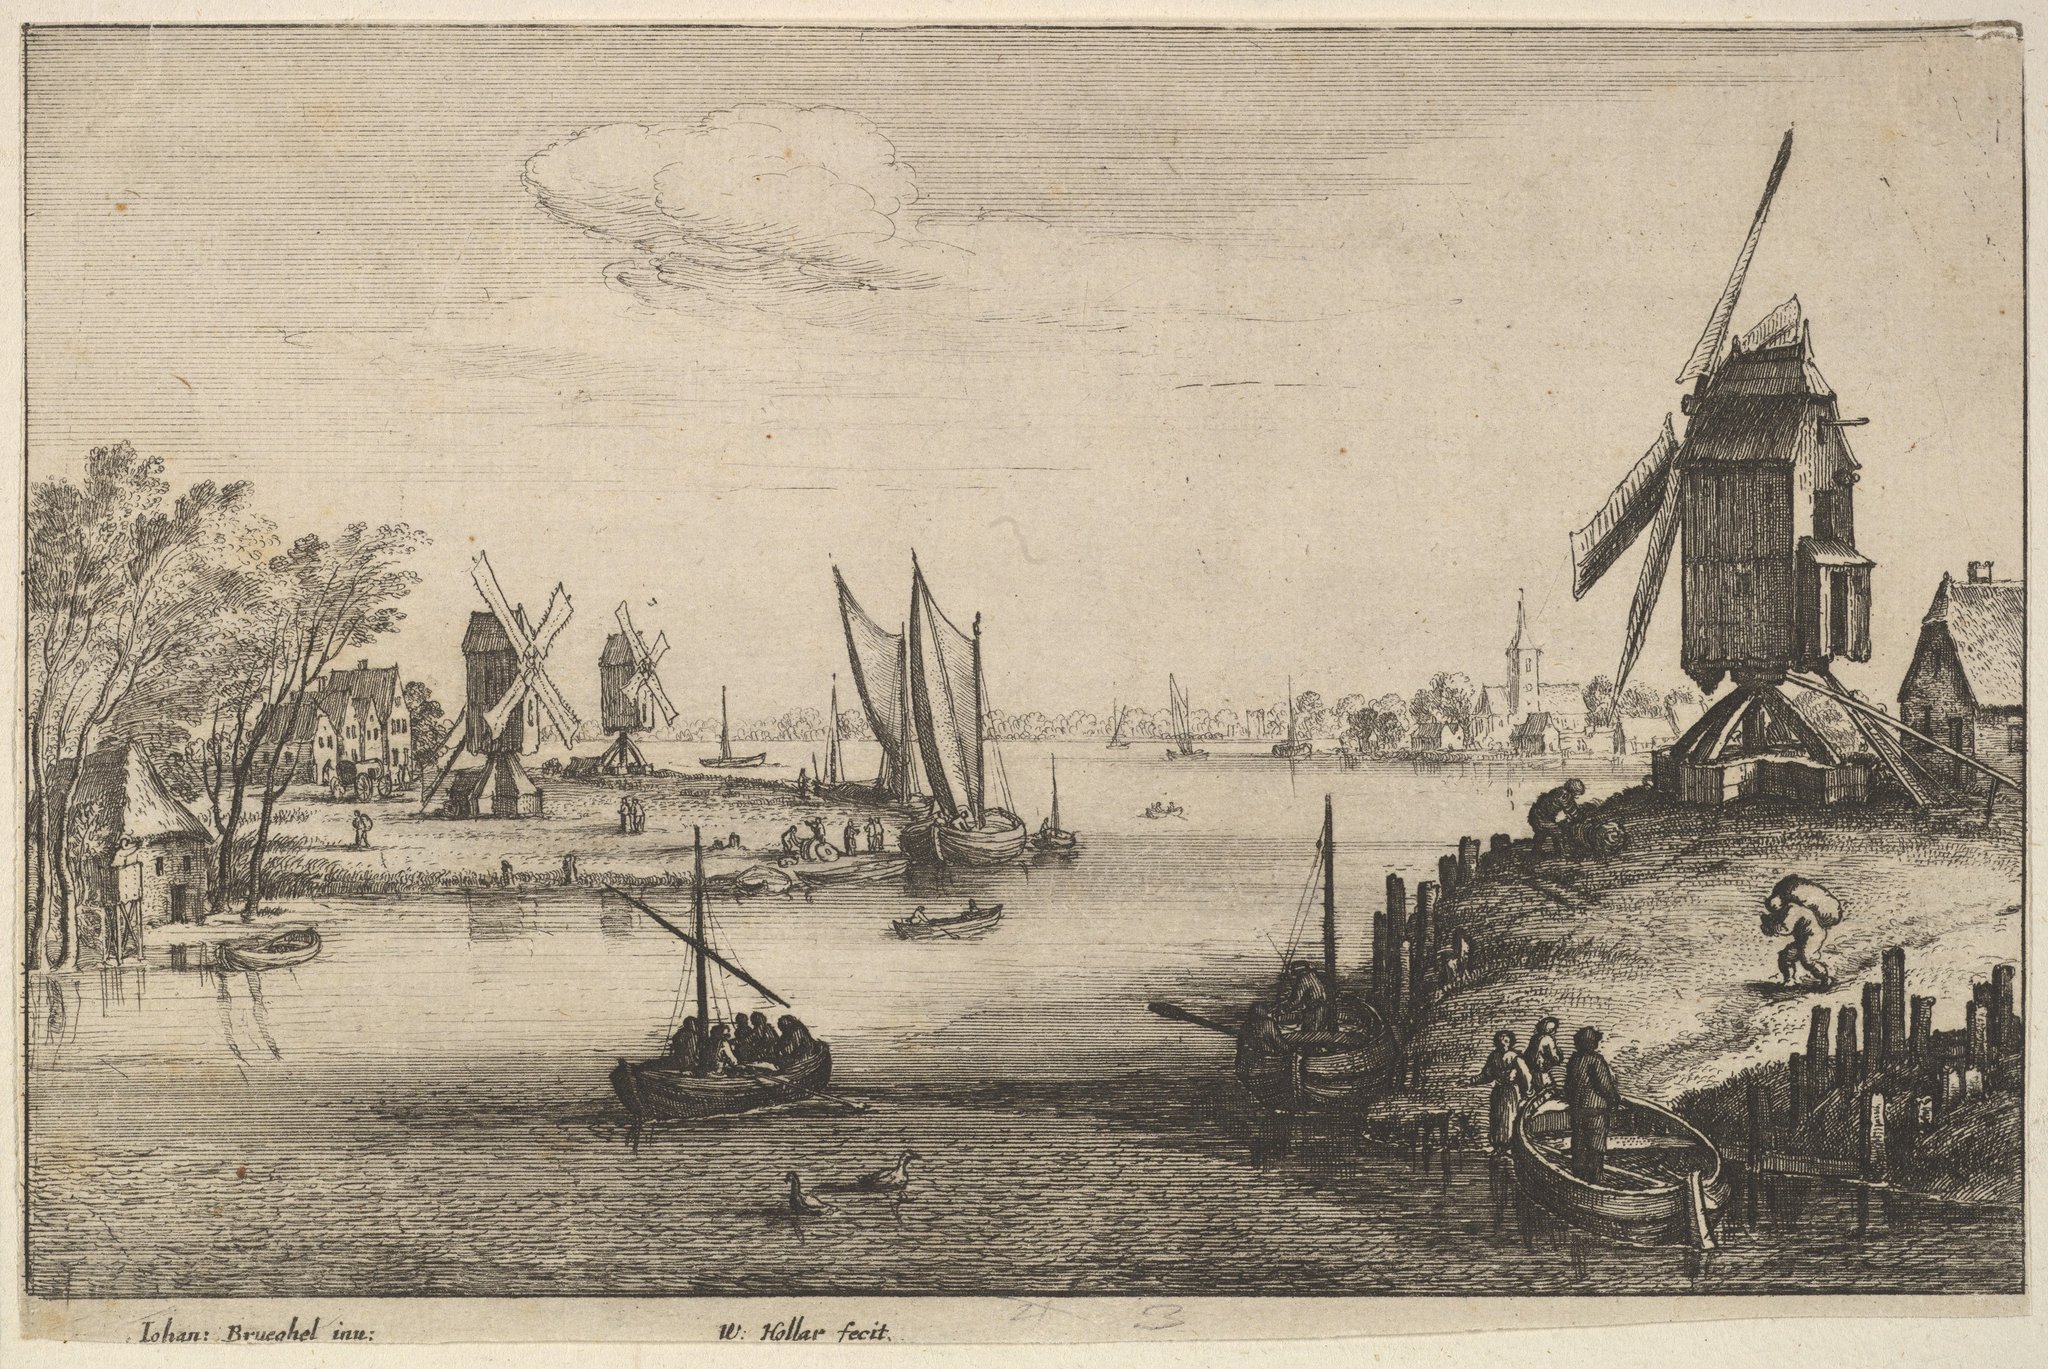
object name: print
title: The Three Windmills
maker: wenceslaus hollar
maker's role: artist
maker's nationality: bohemian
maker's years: 1607-1677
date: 1651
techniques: etching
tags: windmills,villages,rivers,working,boats